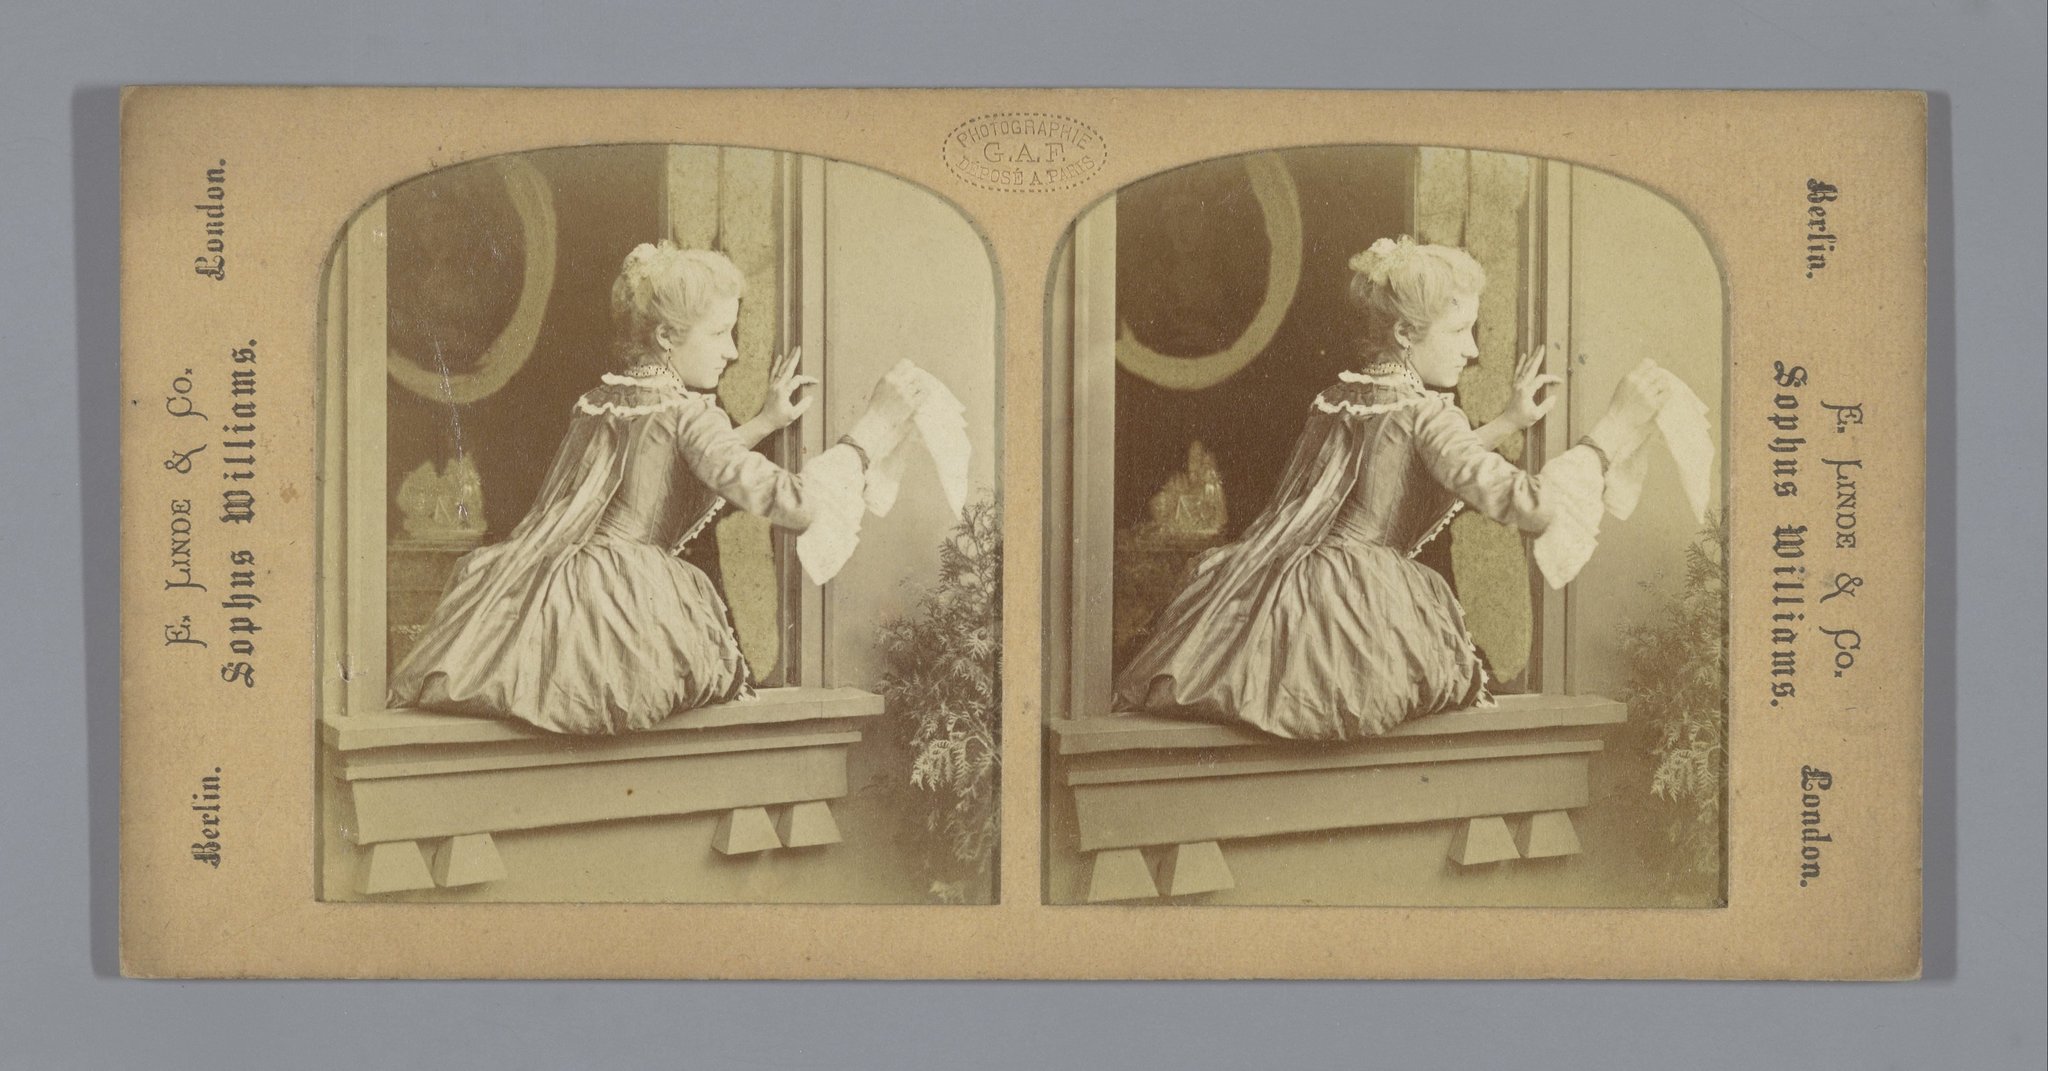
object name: tissue stereograph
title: Jonge vrouw wuift vanuit raam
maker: florent grau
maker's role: manufacturer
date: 1868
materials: cardboard, paper, photographic support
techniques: albumen print, hand coloring, perforating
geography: berlin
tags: waving farewell ~ departure on a journey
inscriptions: inscription: ‘DÉPOSÉ A PARIS’